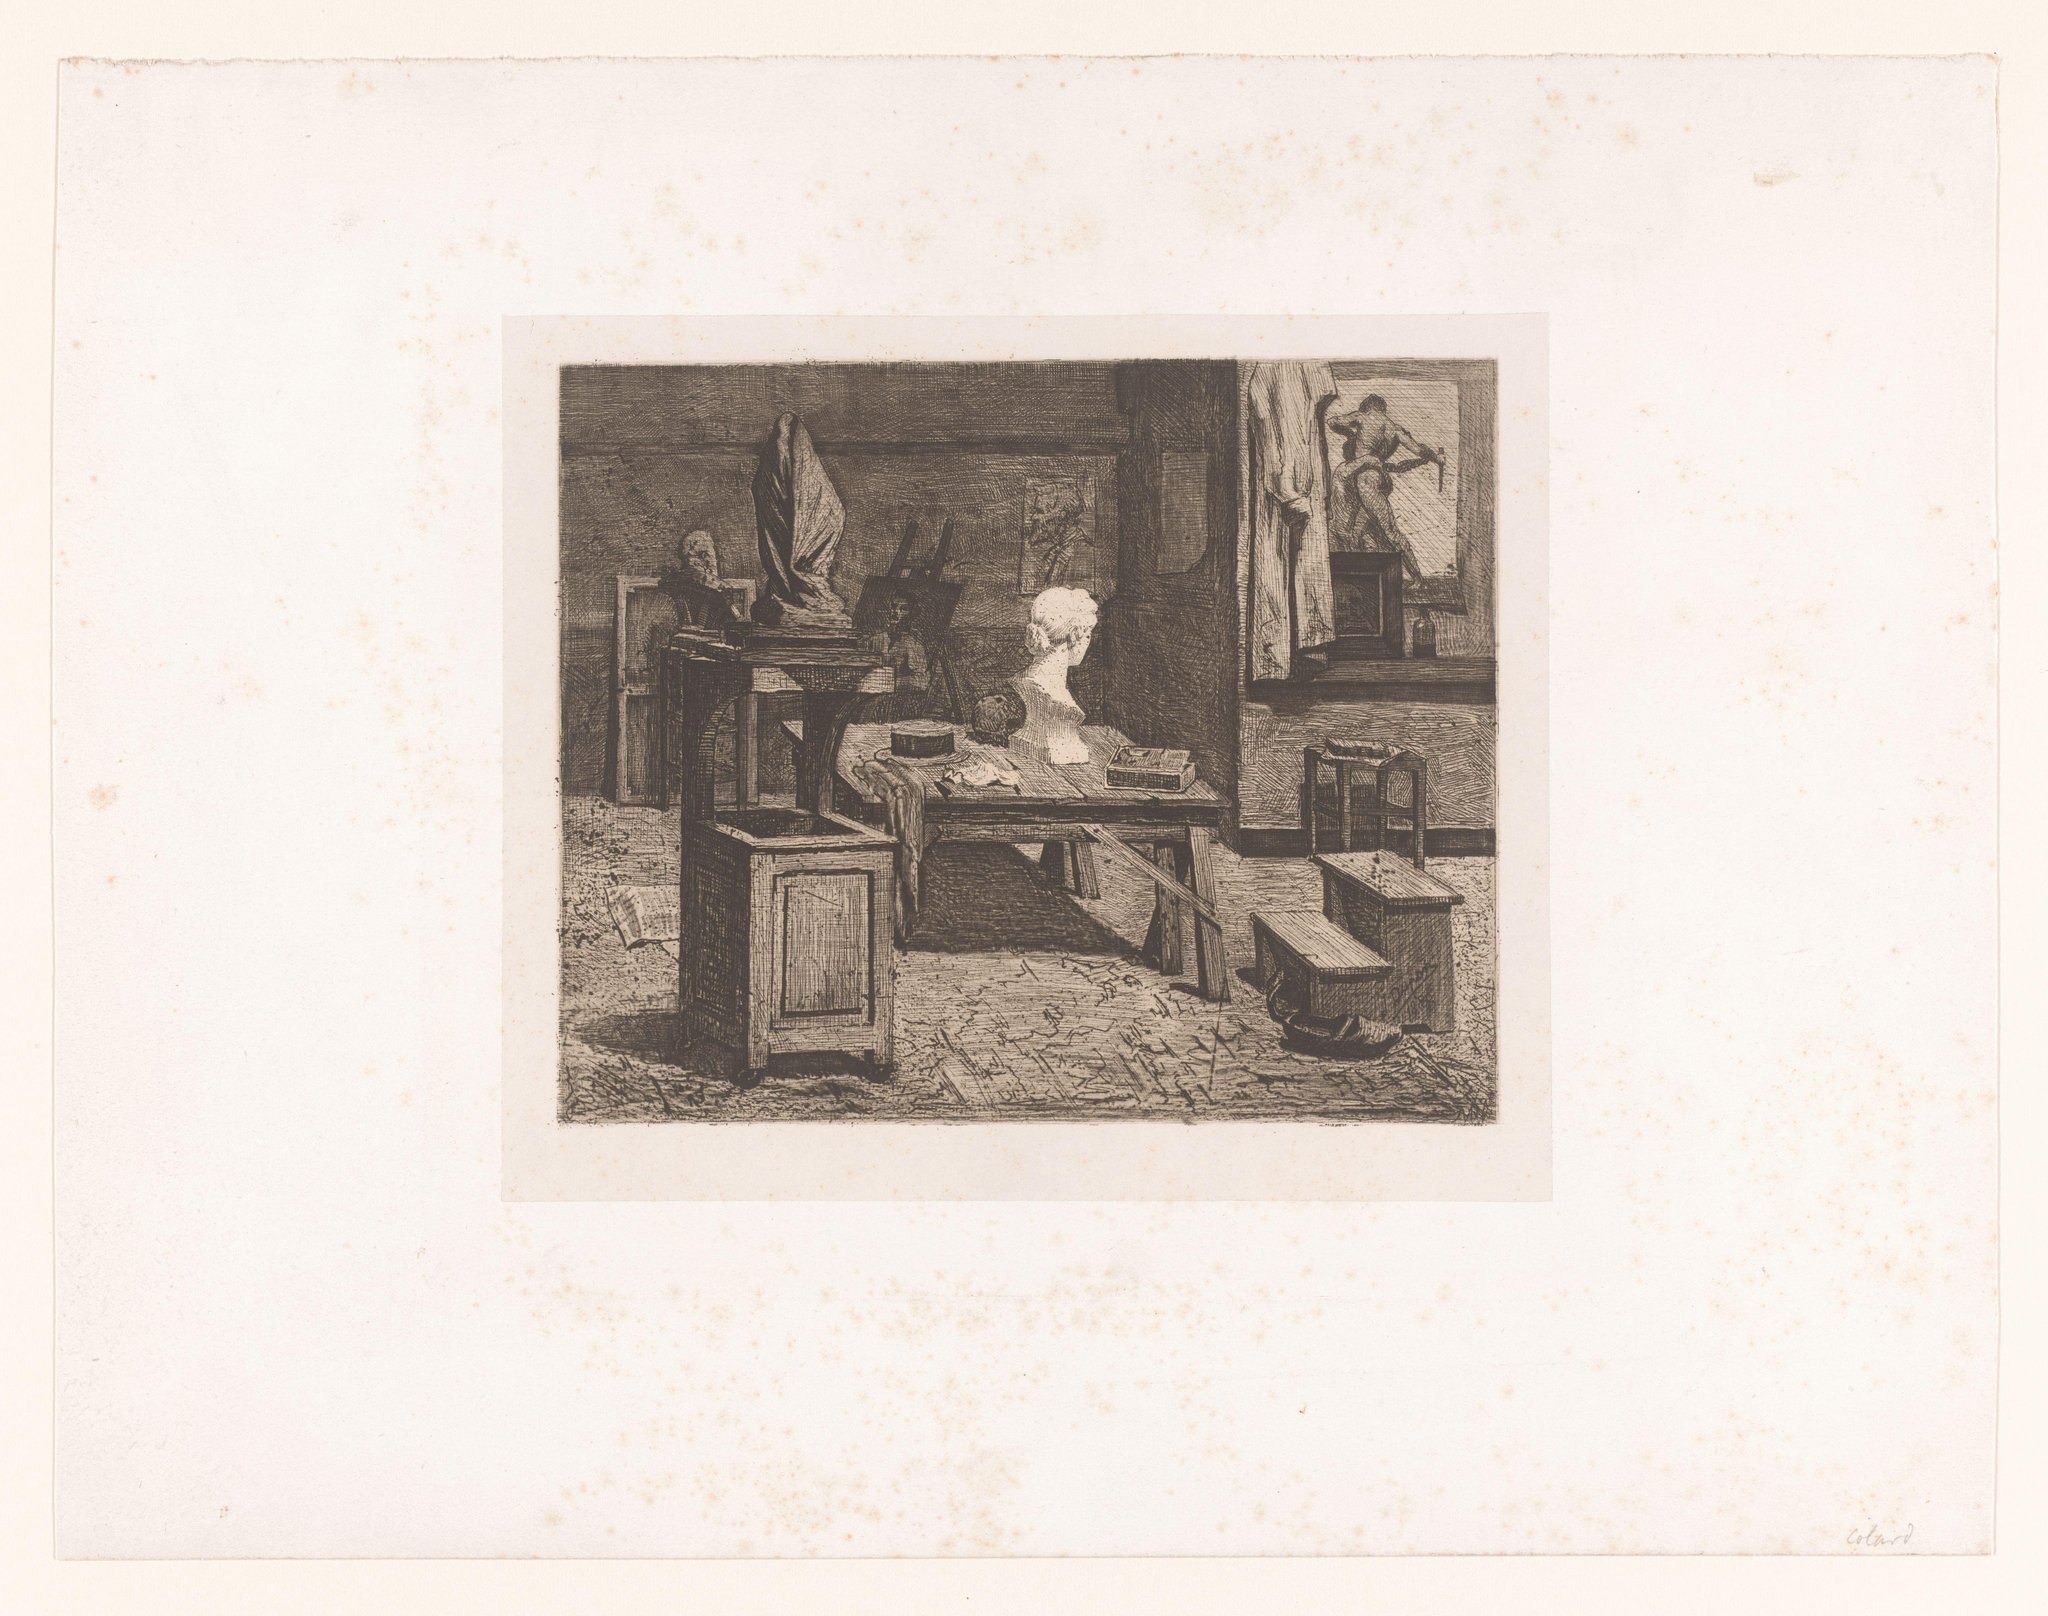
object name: print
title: Werkplaats van Josué Dupon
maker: josué dupon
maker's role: print maker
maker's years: 1864-1935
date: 1874-1909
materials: paper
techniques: etching, intaglio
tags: antwerp, josué dupon, workshop-interior, portrait, self-portrait of graphic artist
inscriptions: collector's mark: Lugt 2228